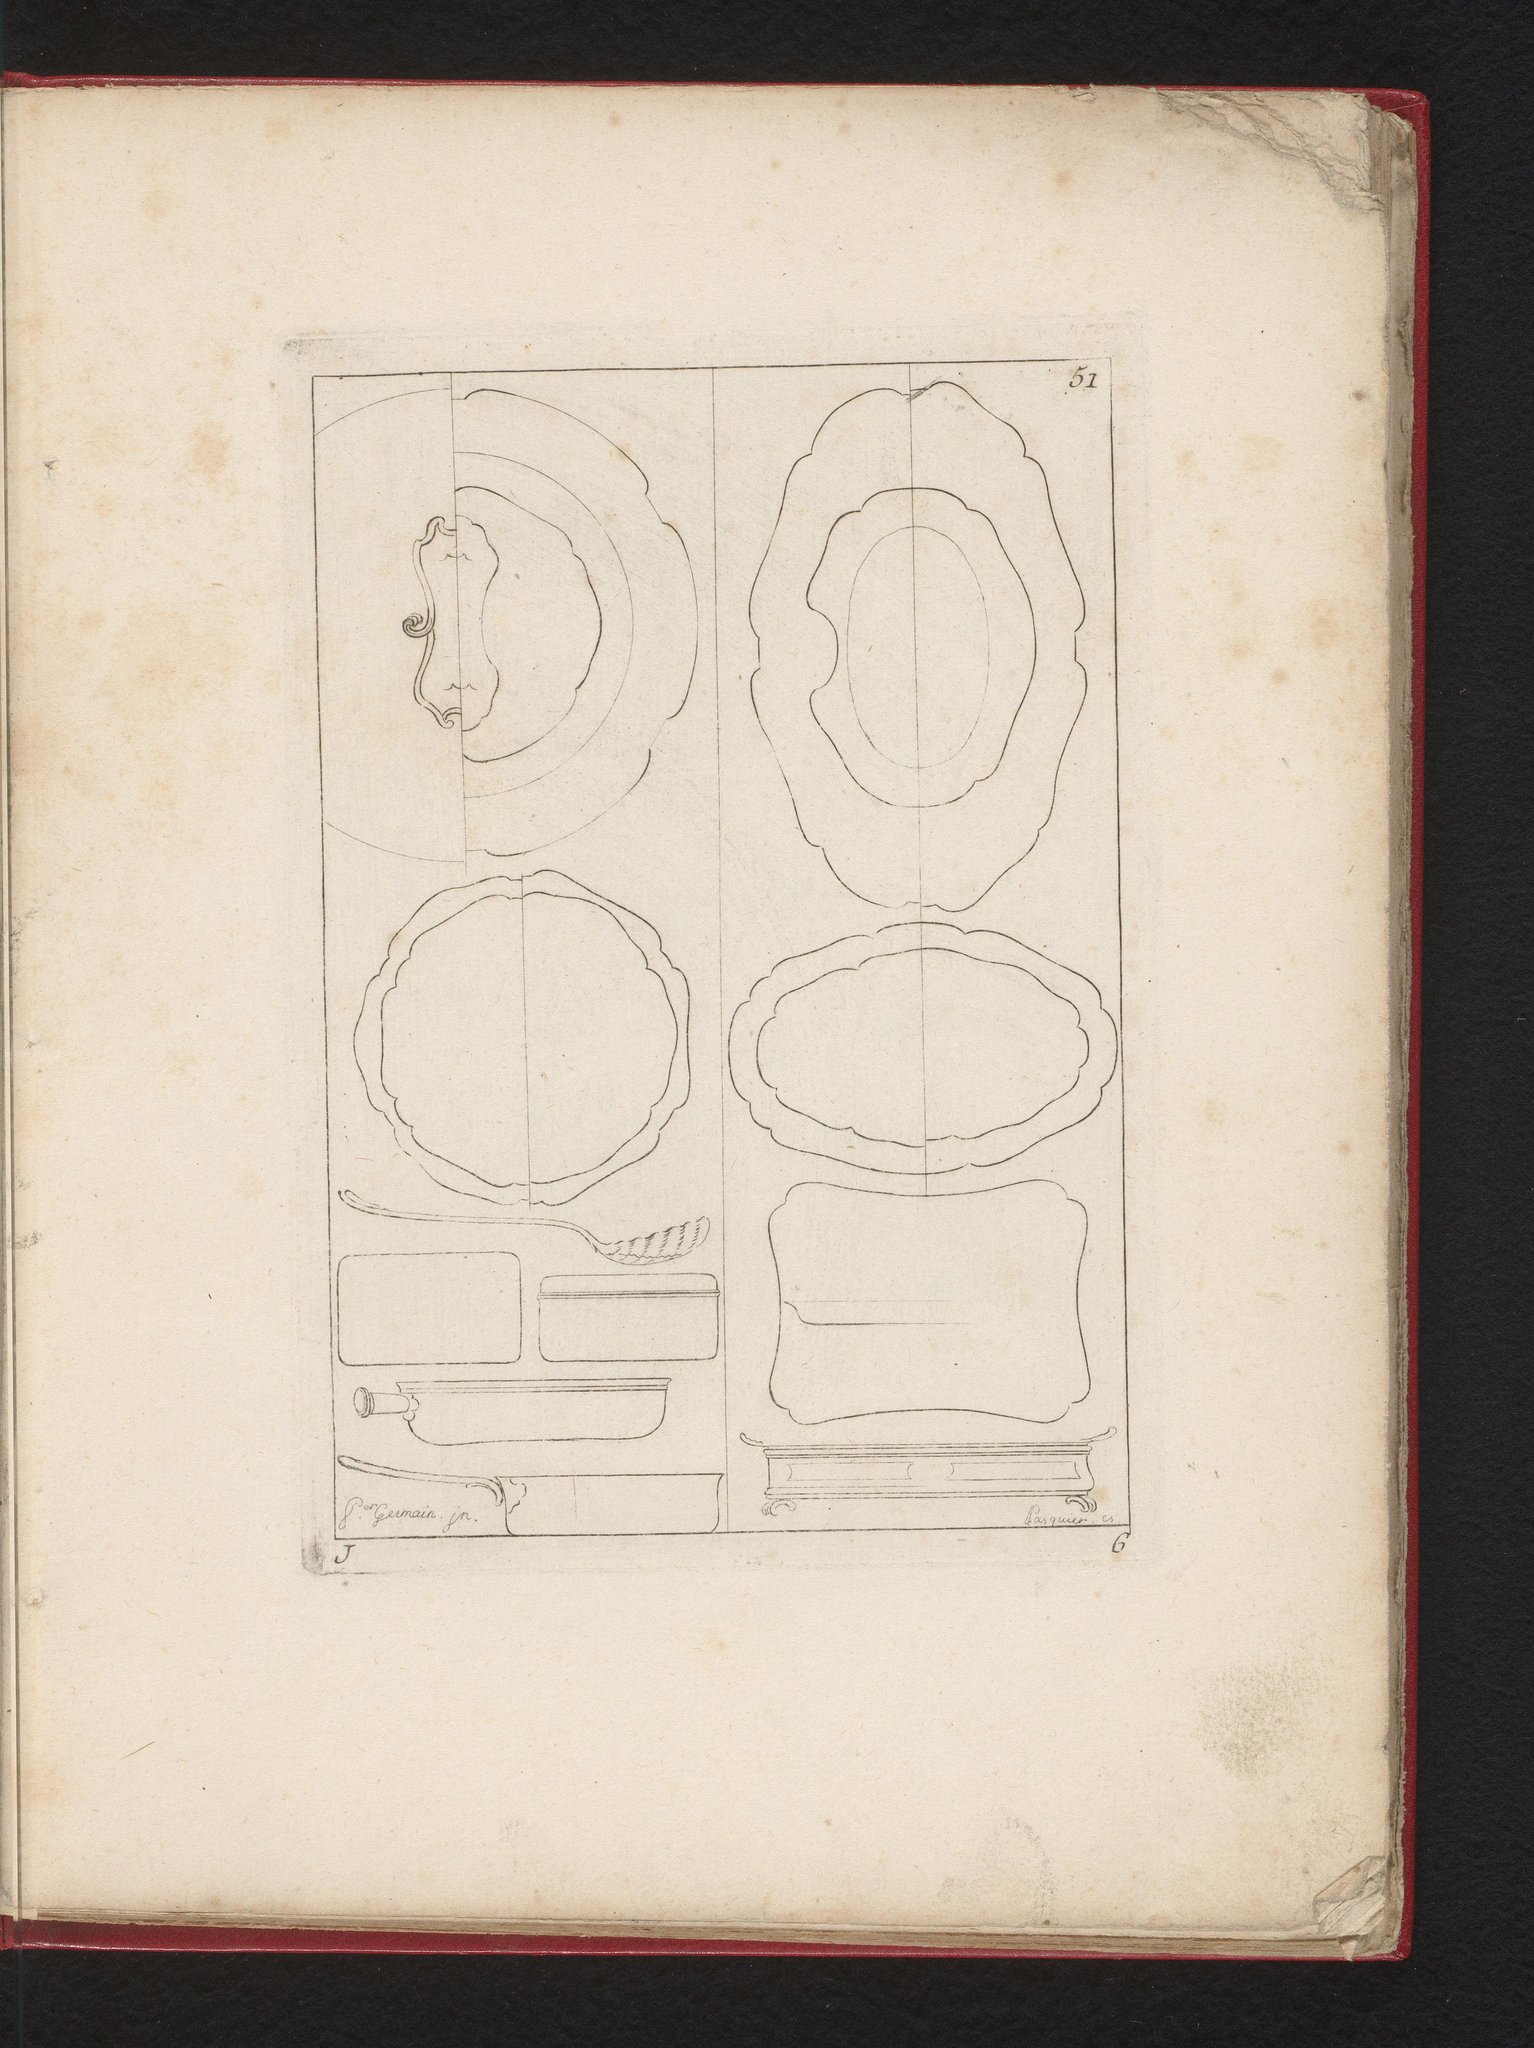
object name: print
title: Contouren van borden, pannen en een schuimspaan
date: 1748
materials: paper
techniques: etching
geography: paris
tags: kitchen-utensils: pan, kitchen-utensils: skimmer, dish, plate, saucer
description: Een aantal van de objecten in deze reeks heeft een eigen ondertitel, die verwijst naar genummerde 'cahiers' (afleveringen) waarin de prenten werden uitgegeven. Het is onduidelijk welke objecten recies bij welke aflevering horen. Daarom is die ondertitel enkel verwerkt bij de prent waarop die voorkomt.